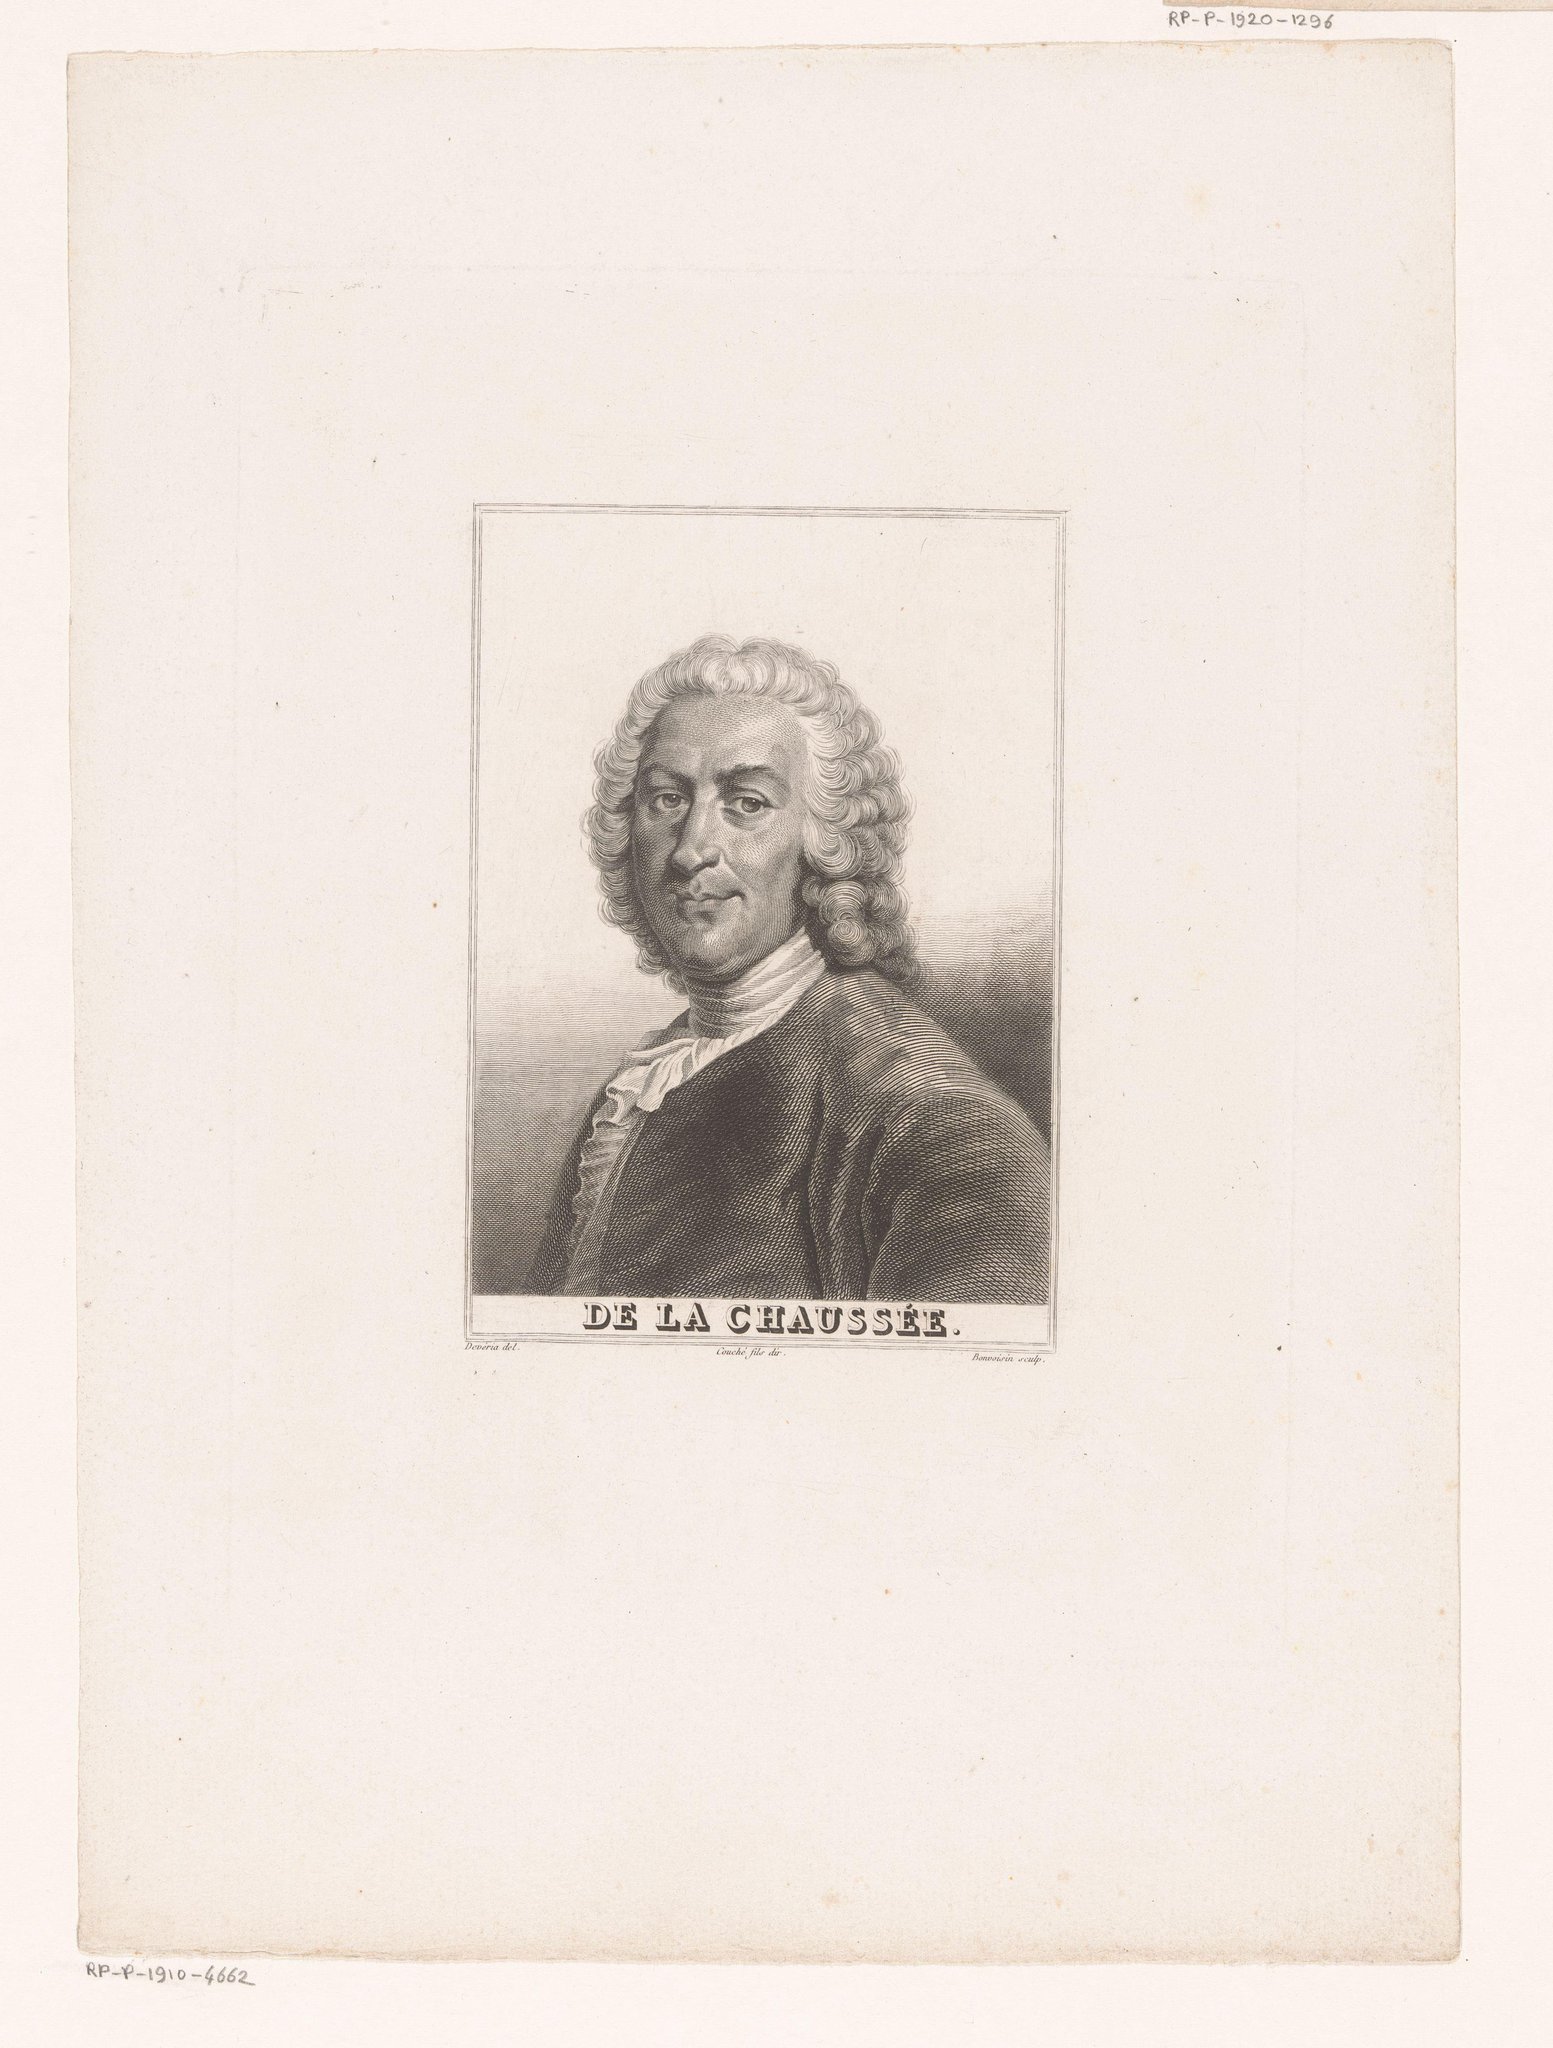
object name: book illustration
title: De La Chaussée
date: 1824-1826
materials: paper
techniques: engraving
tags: paris, historical persons, portrait of a writer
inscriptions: collector's mark: Lugt 2228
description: Prent uit: MM. Ch. Nodier, P. Lepeintre, Lemazurier, L. Thiesse, A. Lesourd en L. Castel. Bibliothèque dramatique ou répertoire universel du théâtre français. Parijs: Vve Dabo, 1824-1826.